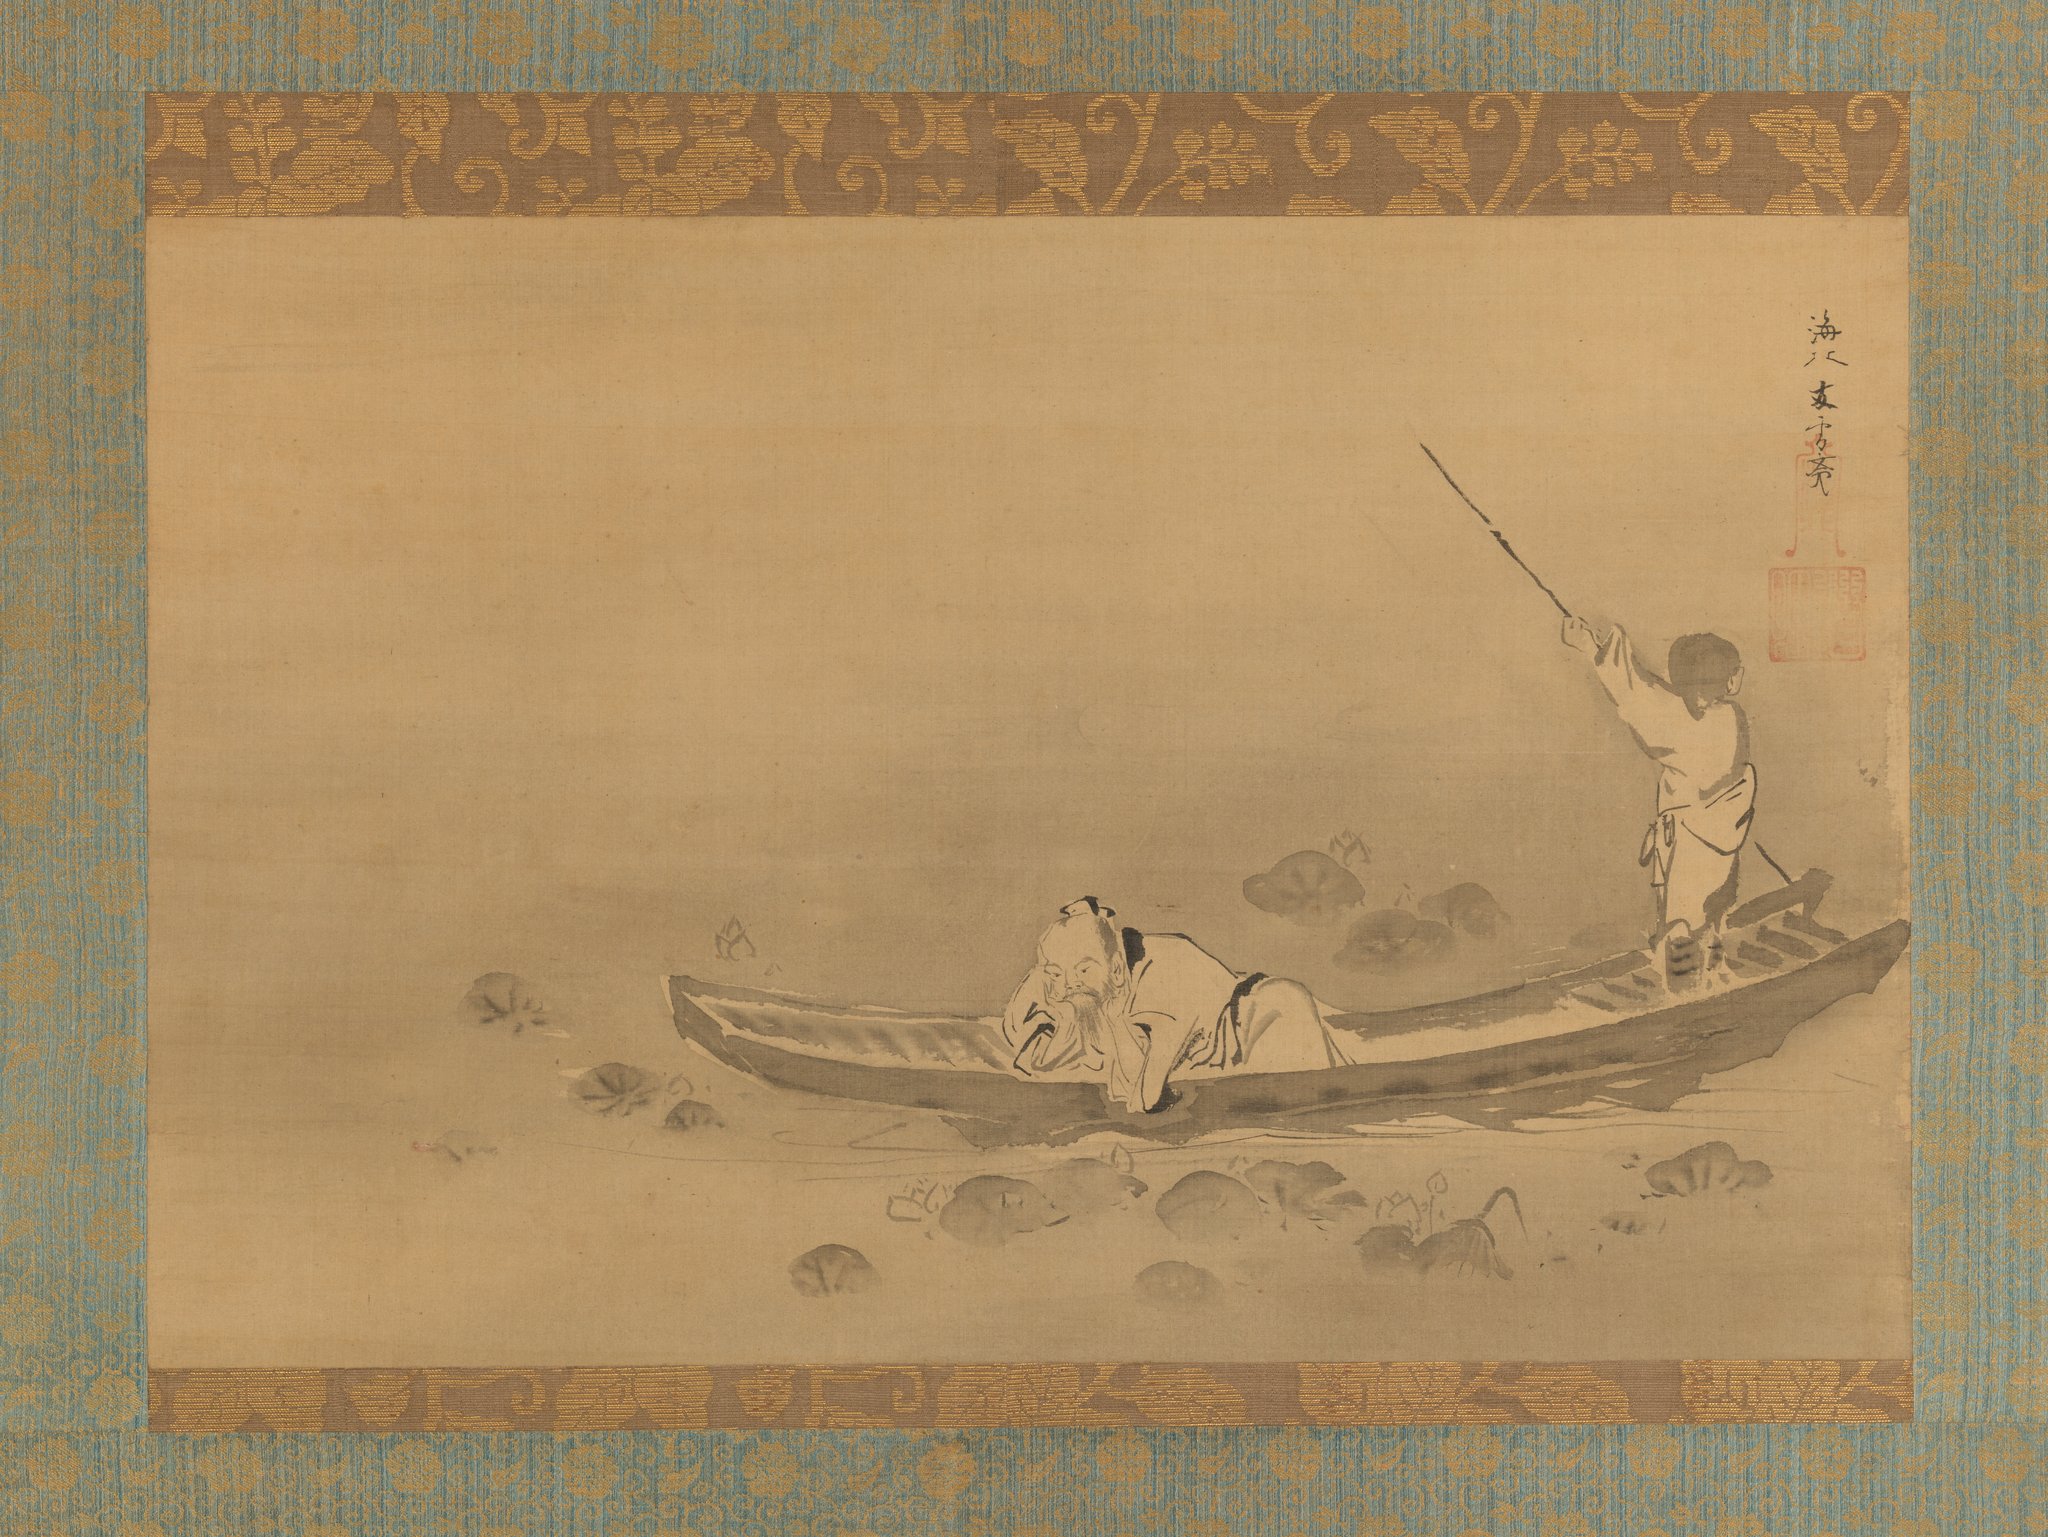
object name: hanging scroll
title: Zhou Maoshu Admiring Lotuses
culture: japanese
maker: kaihō yūsetsu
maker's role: artist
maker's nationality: japanese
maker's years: 1598-1677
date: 1634-1666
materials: ink, silk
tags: men,boats